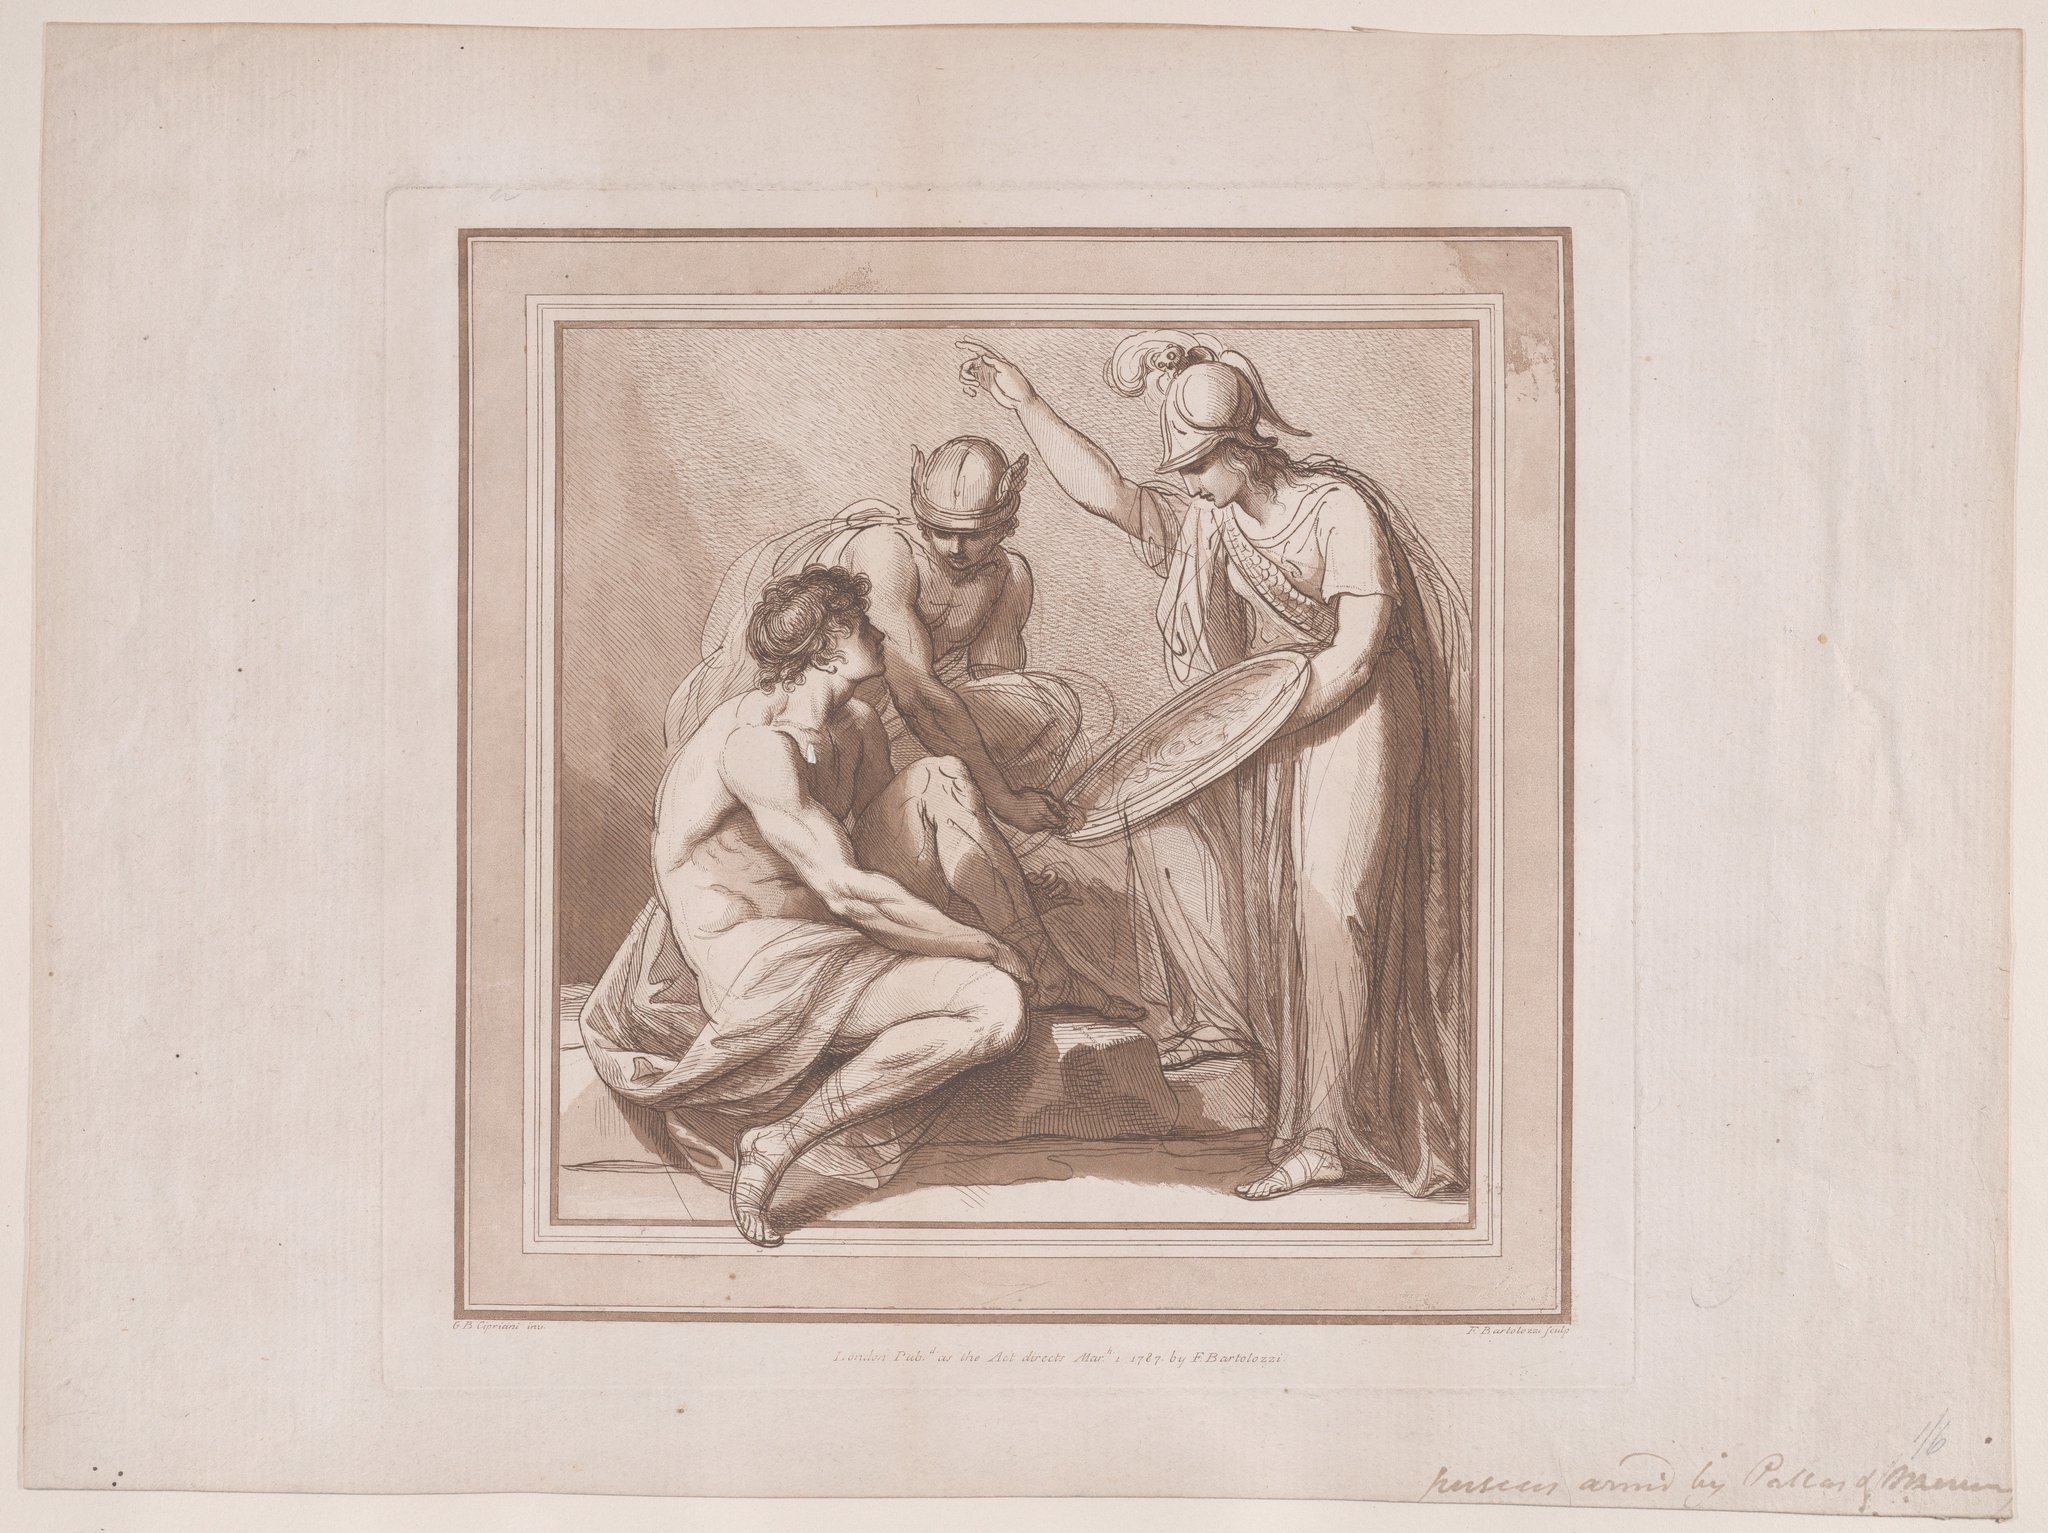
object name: print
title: Minerva and Mercury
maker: domenico marchetti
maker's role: artist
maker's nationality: italian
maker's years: 1780-1844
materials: ink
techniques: aquatint, etching, printing